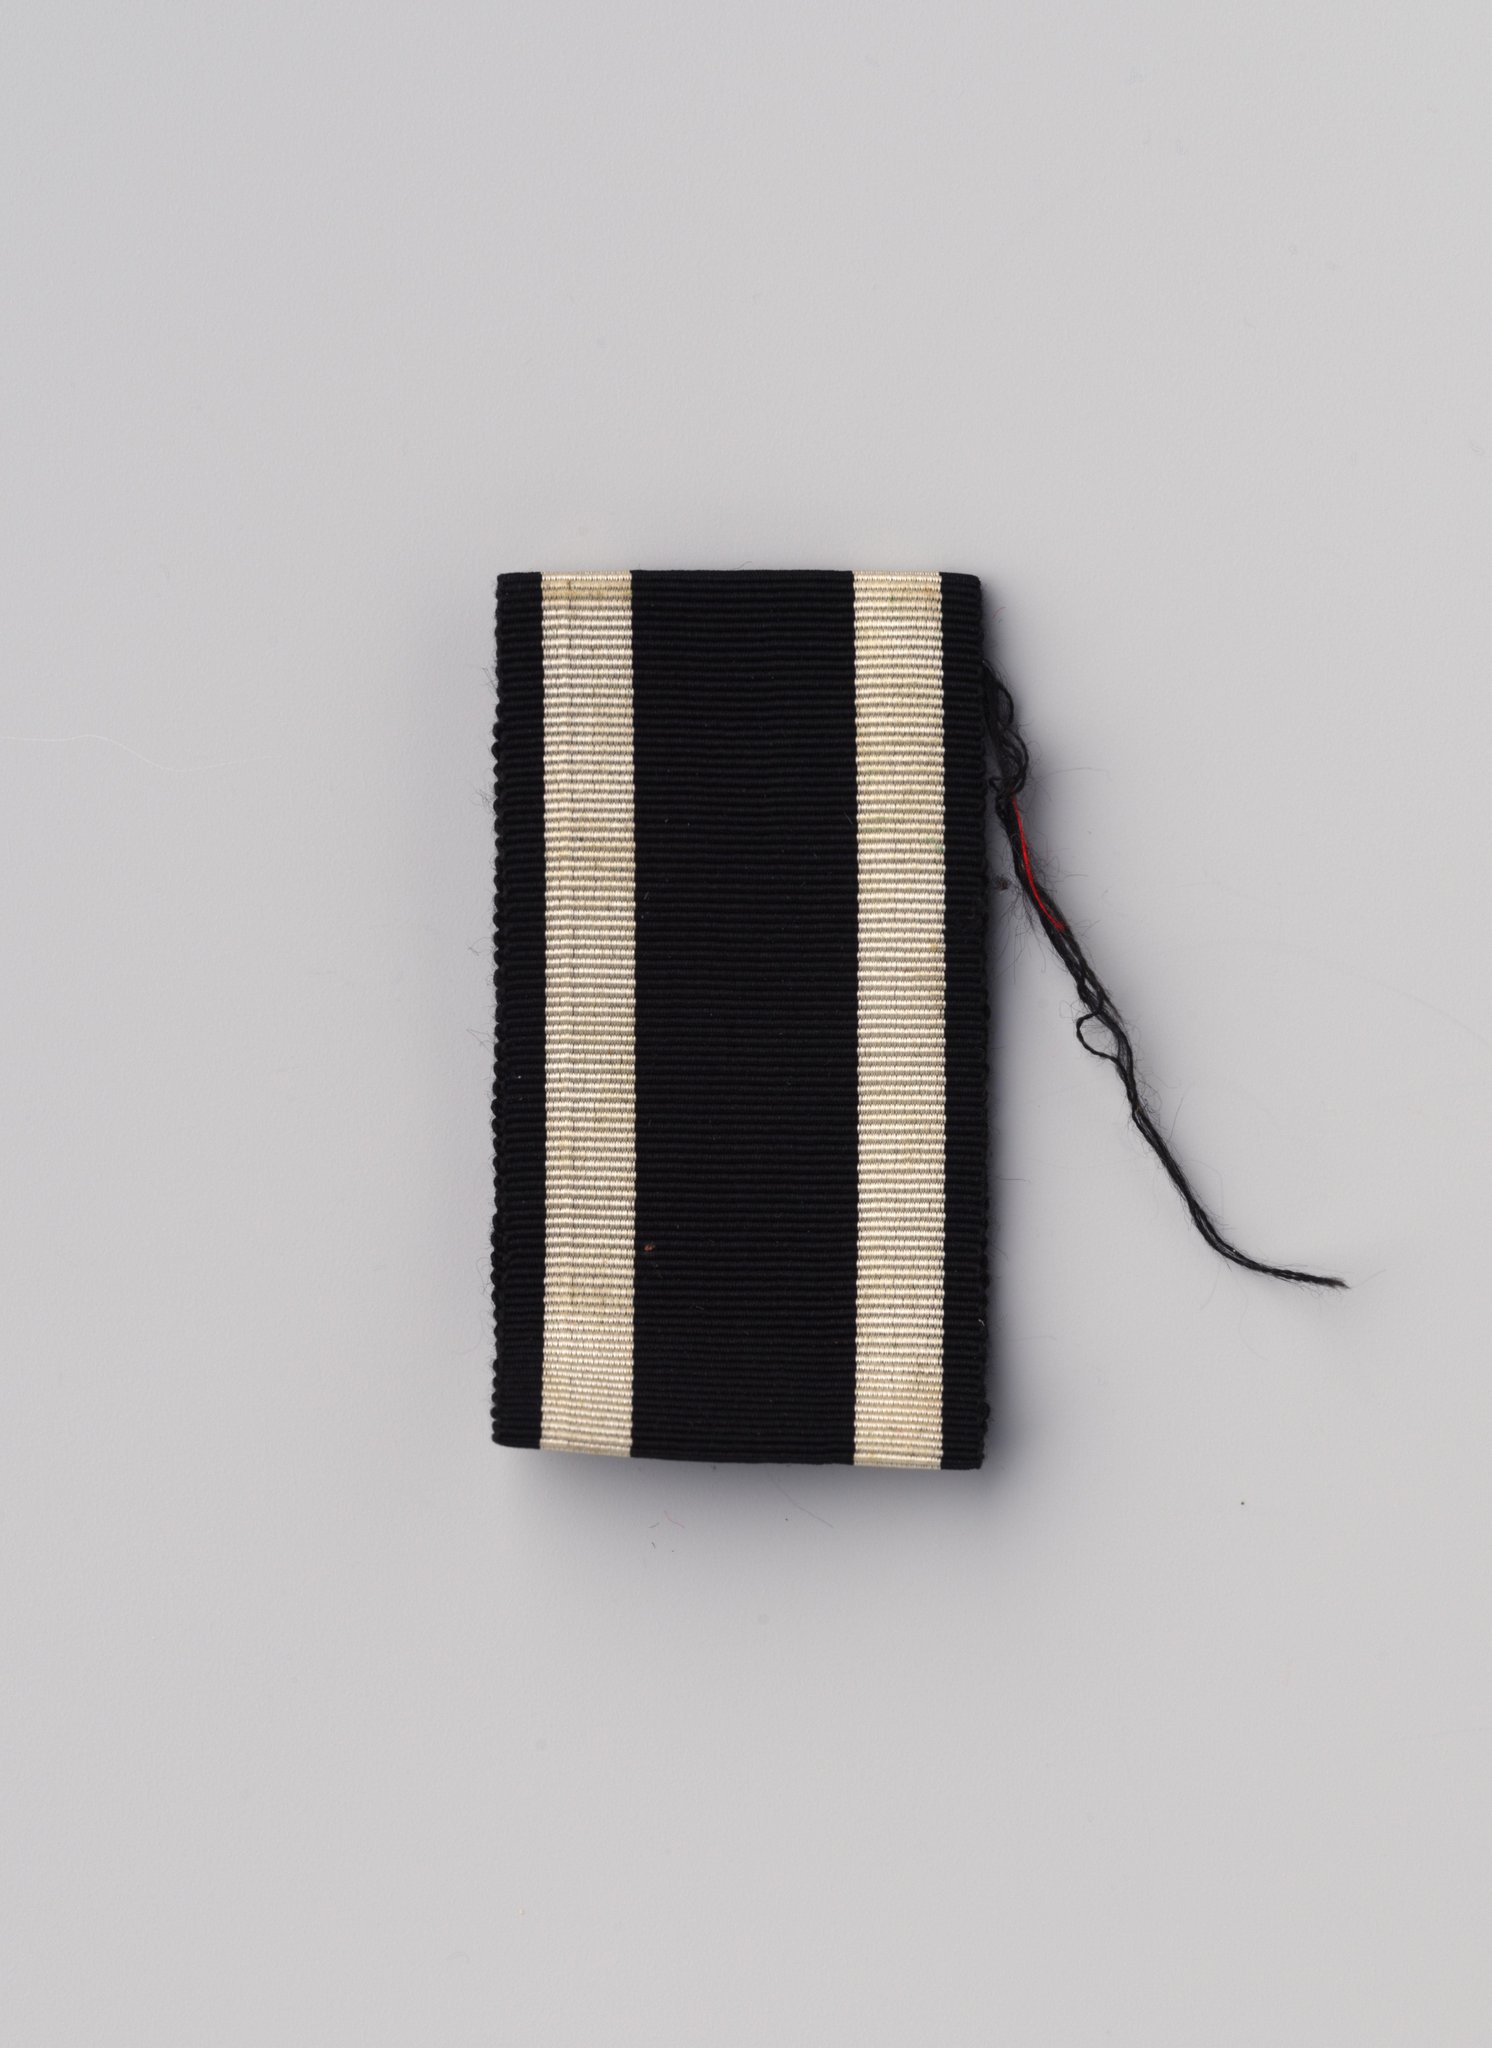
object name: ribbon material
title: Lint, zwart-wit gestreept, horend bij een onderscheiding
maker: Anonymous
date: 1900-1925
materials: silk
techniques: weave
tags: eugen wachenheimer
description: Dit object is onderdeel van de nalatenschap van Isabel Elon-Wachenheimer (1928-2010). Tot haar overlijden behoorde het samen met de andere objecten uit de nalatenschap tot haar privédomein van Isabel Wachenheimer. In die particuliere context zijn deze objecten tezamen en individueel aandenkens - aan de jeugd, ouders en familie van Isabel Wachenheimer vóór en tijdens de Shoah en aan haar leven na de Tweede Wereldoorlog. Isabel Wachenheimer, die van juni 1943 tot mei 1945 gevangen zat in Kamp Westerbork, Theresienstadt, Auschwitz, Lenzing a/d Oberdonau (een buitenkamp van Mauthausen), overleefde de Shoah. Haar ouders – Eugène Wachenheimer en Else Wachenheimer-Moos - werden op 14 oktober 1944 in Auschwitz-Birkenau vermoord.